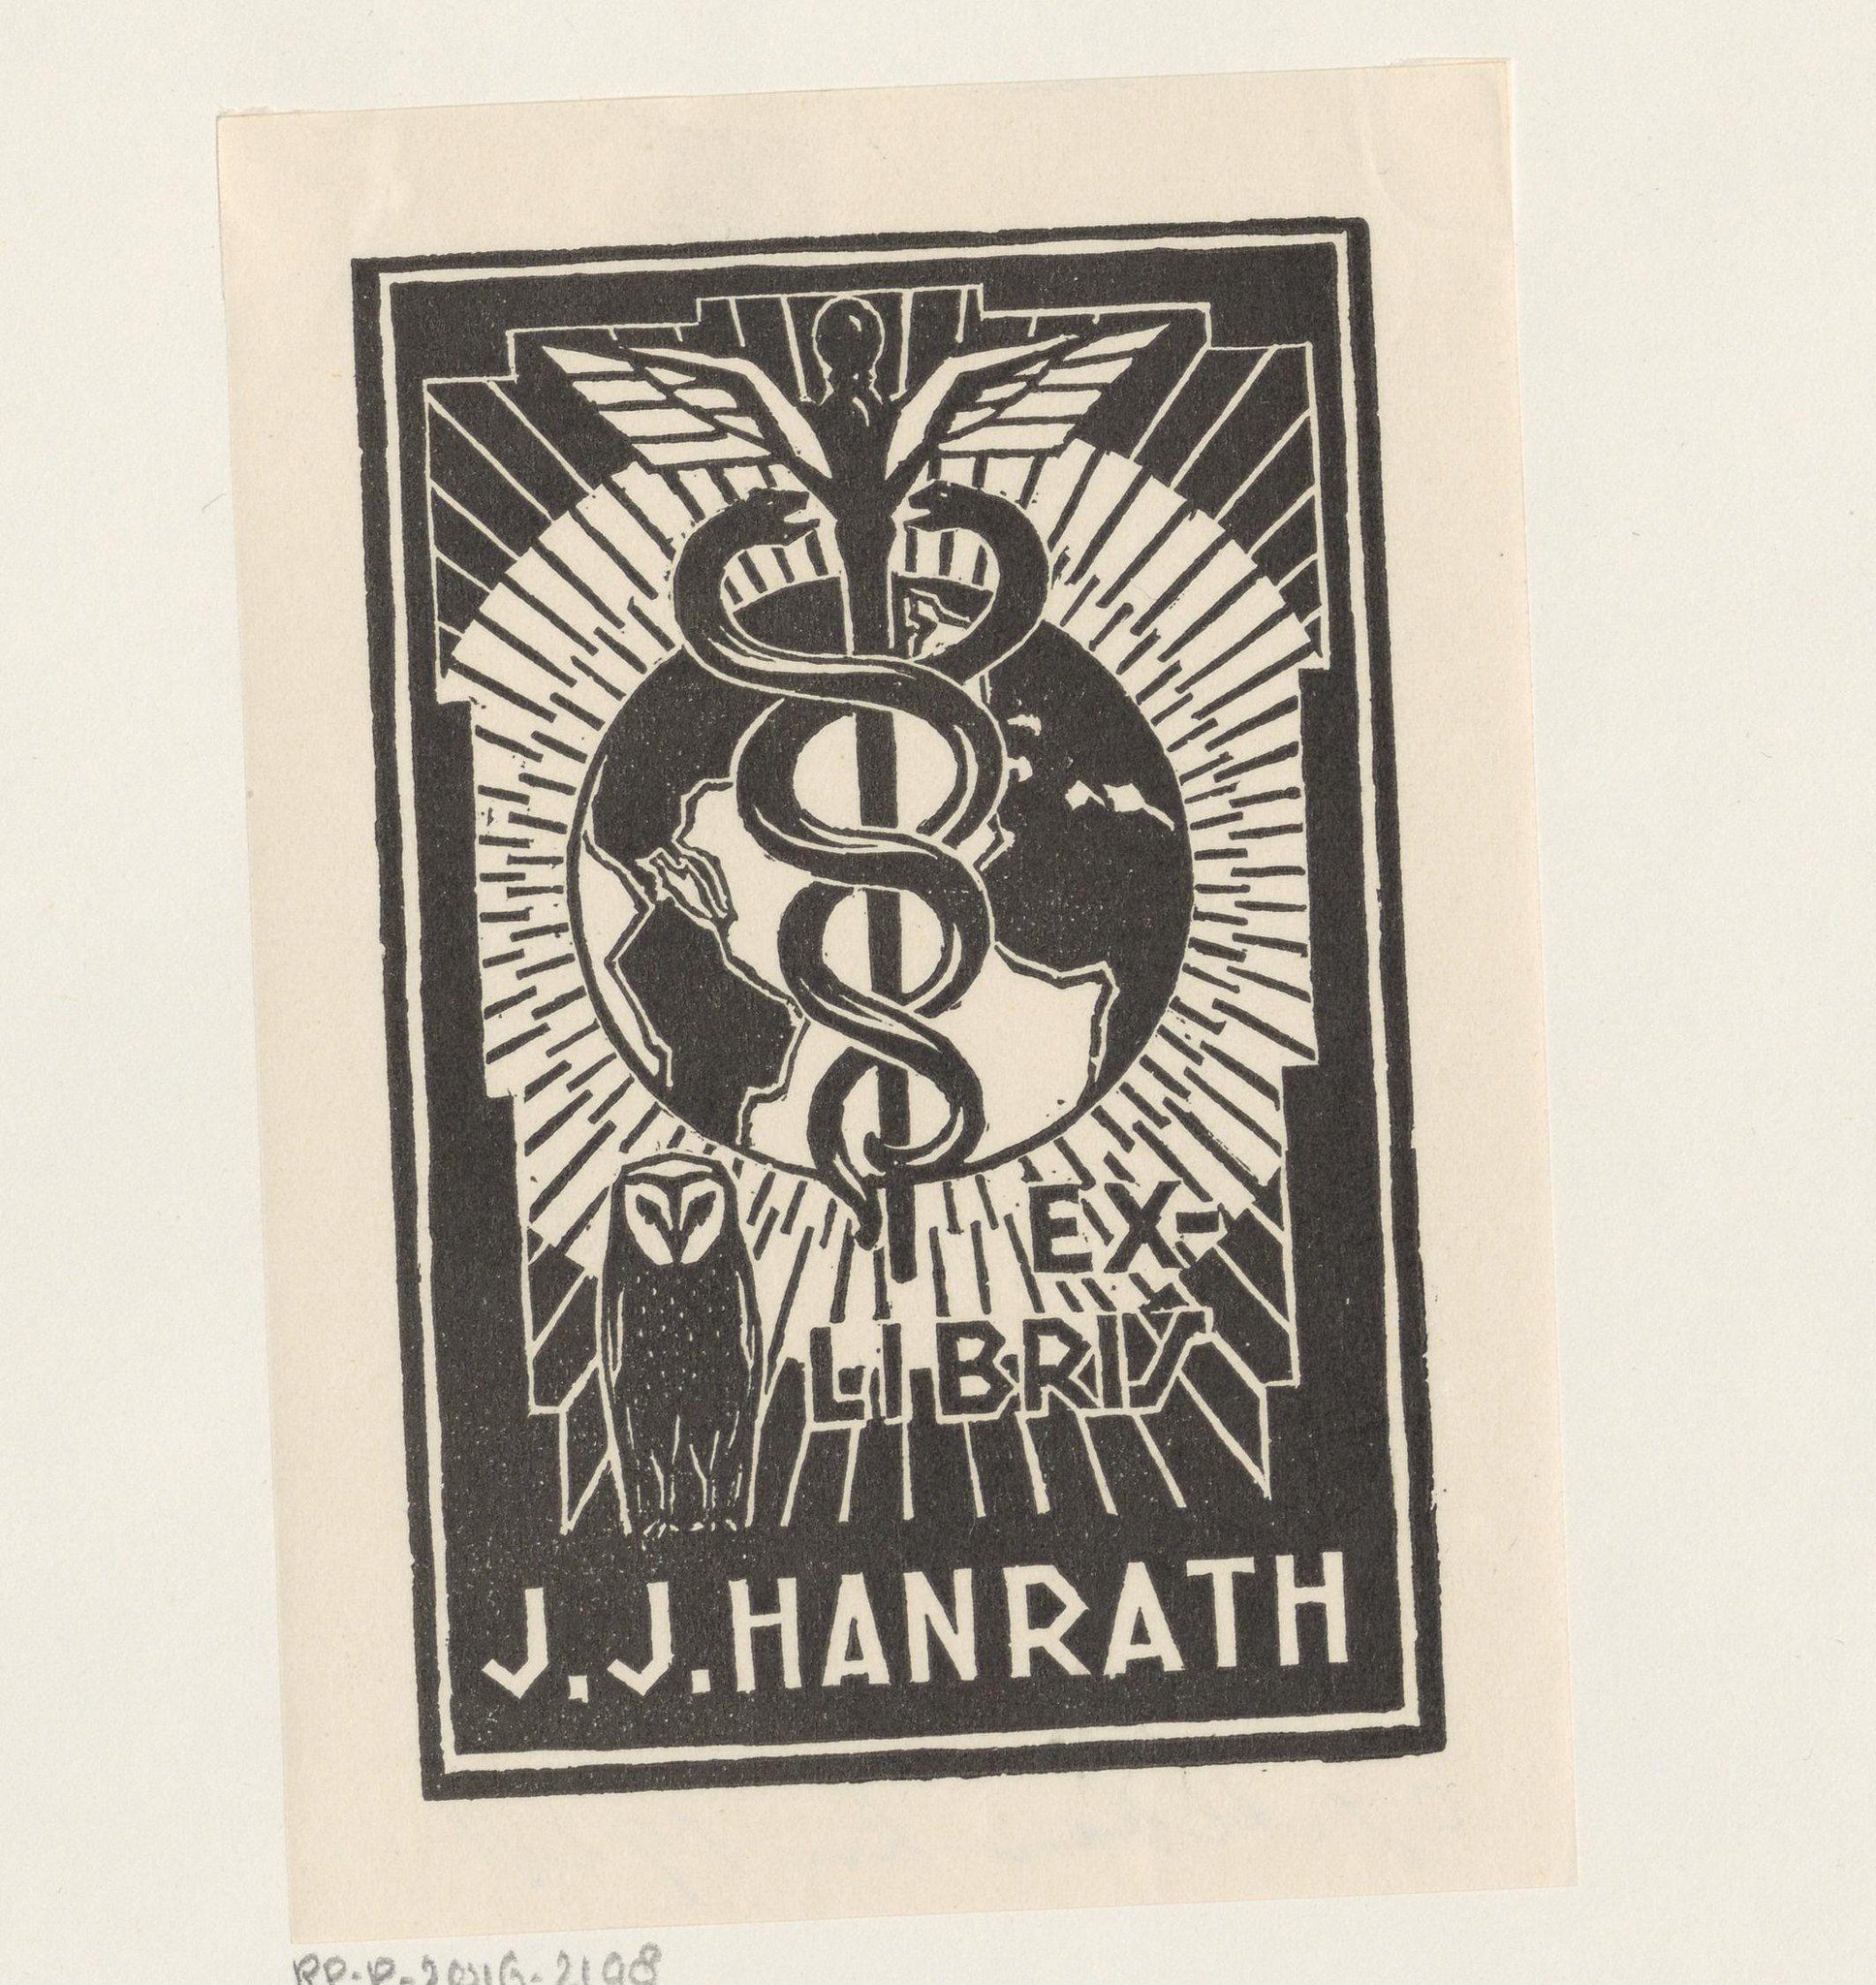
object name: bookplate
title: Ex libris van J.J. Hanrath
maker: constant joseph alban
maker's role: painter, print maker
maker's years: 1873-1944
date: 1928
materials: paper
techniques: linocut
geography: netherlands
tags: owls, caduceus (staff with two snakes, attribute of mercury), globe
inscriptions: signature, date and inscription: ‘J.C. Alban Lin 1928’